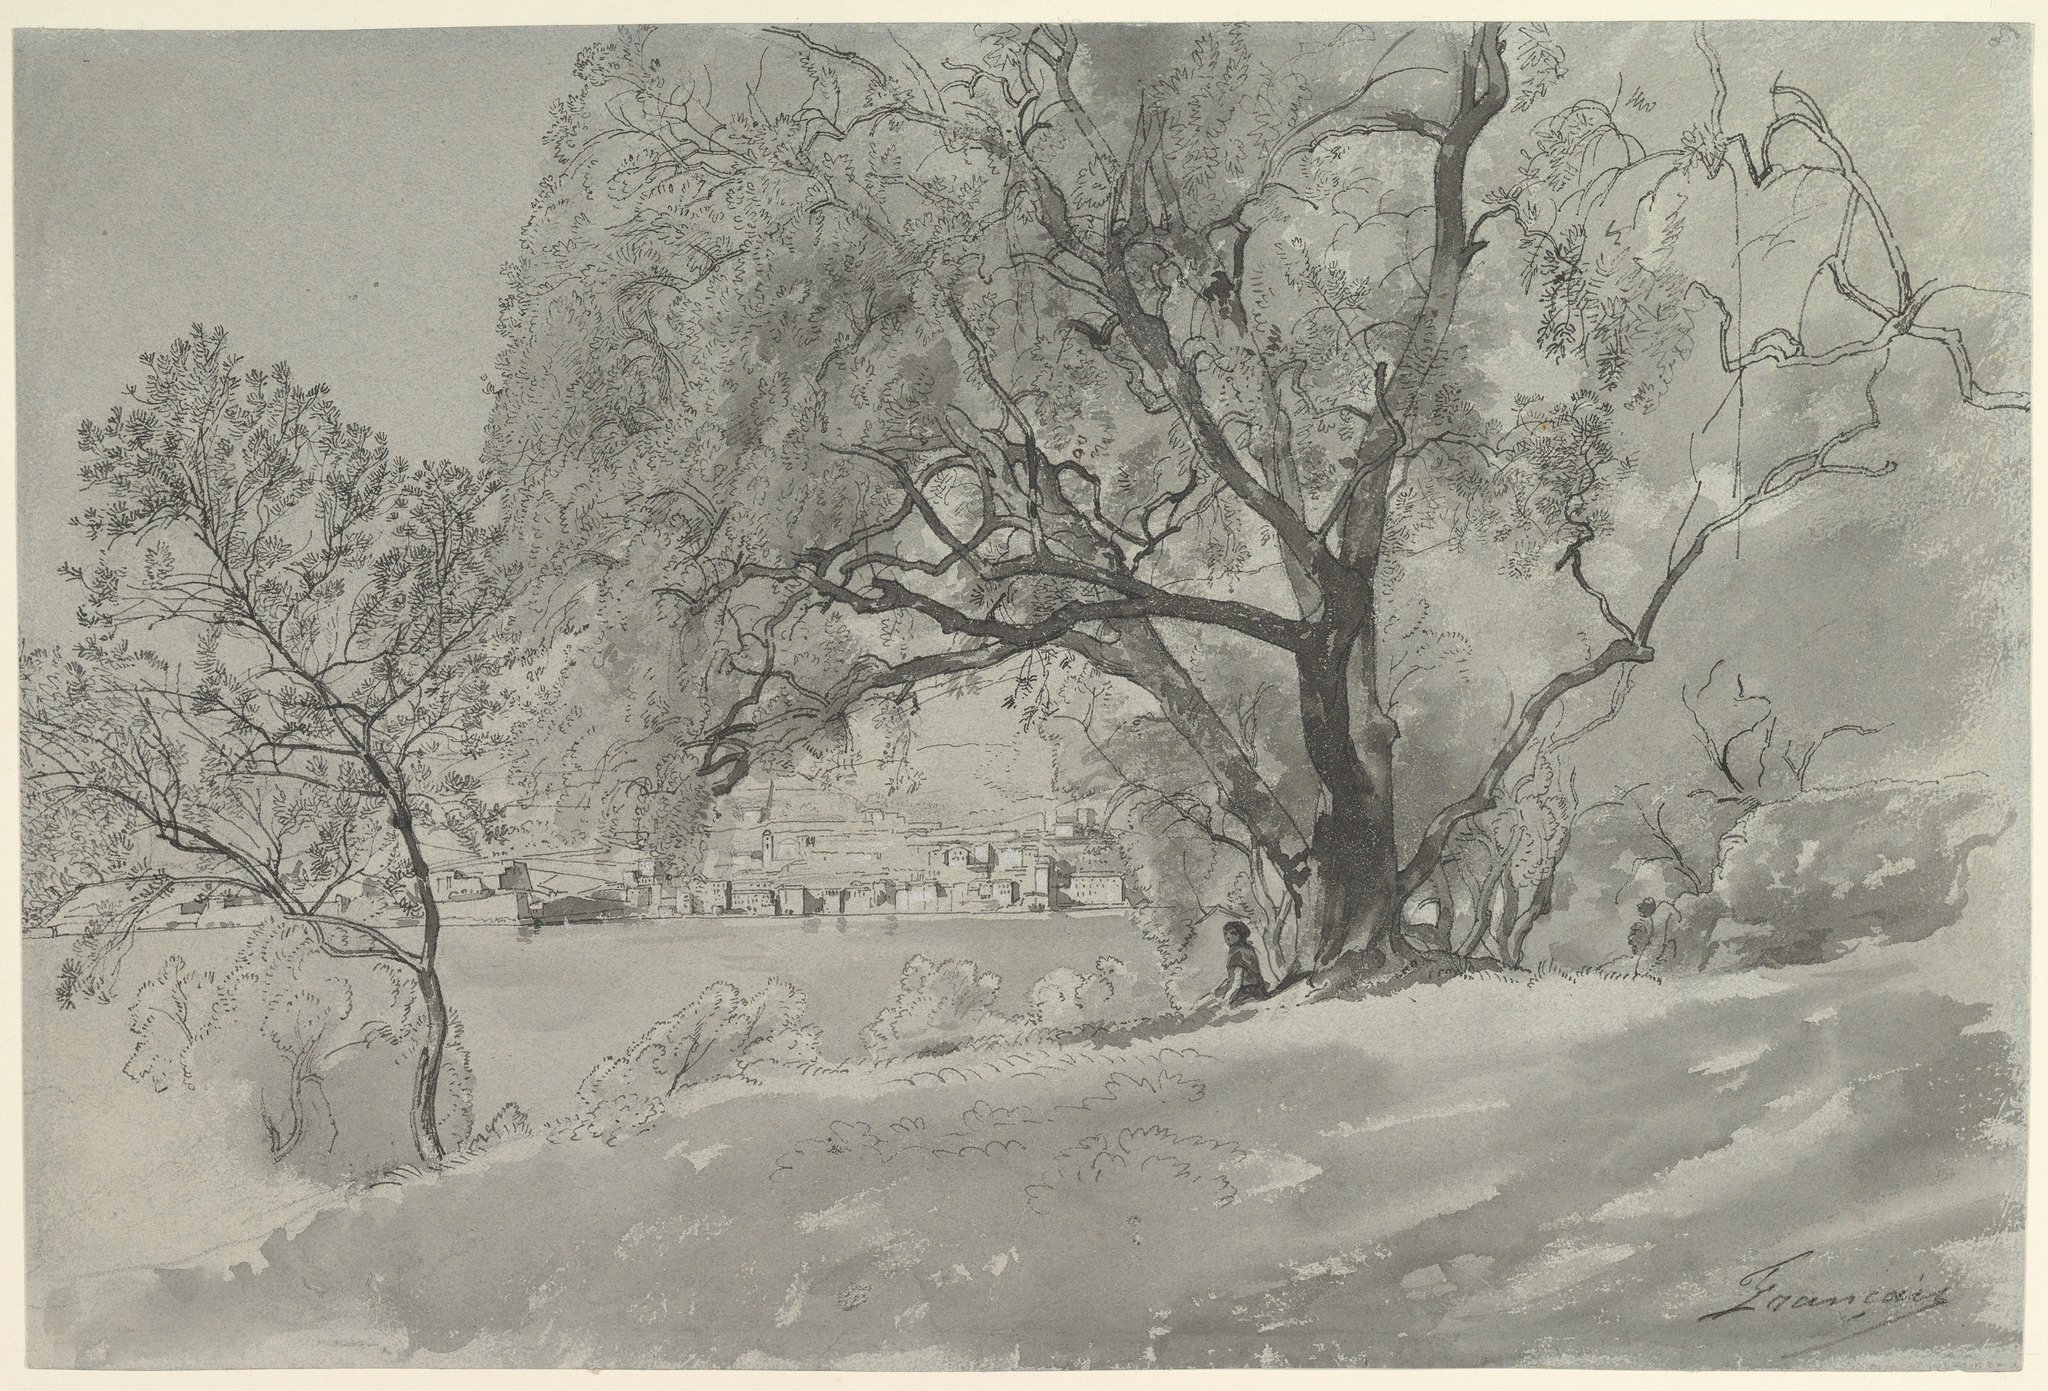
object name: drawing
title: Seated Figure by a Lake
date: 1801-1900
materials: ink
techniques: brush, pen, wash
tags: human figures,lakes,trees